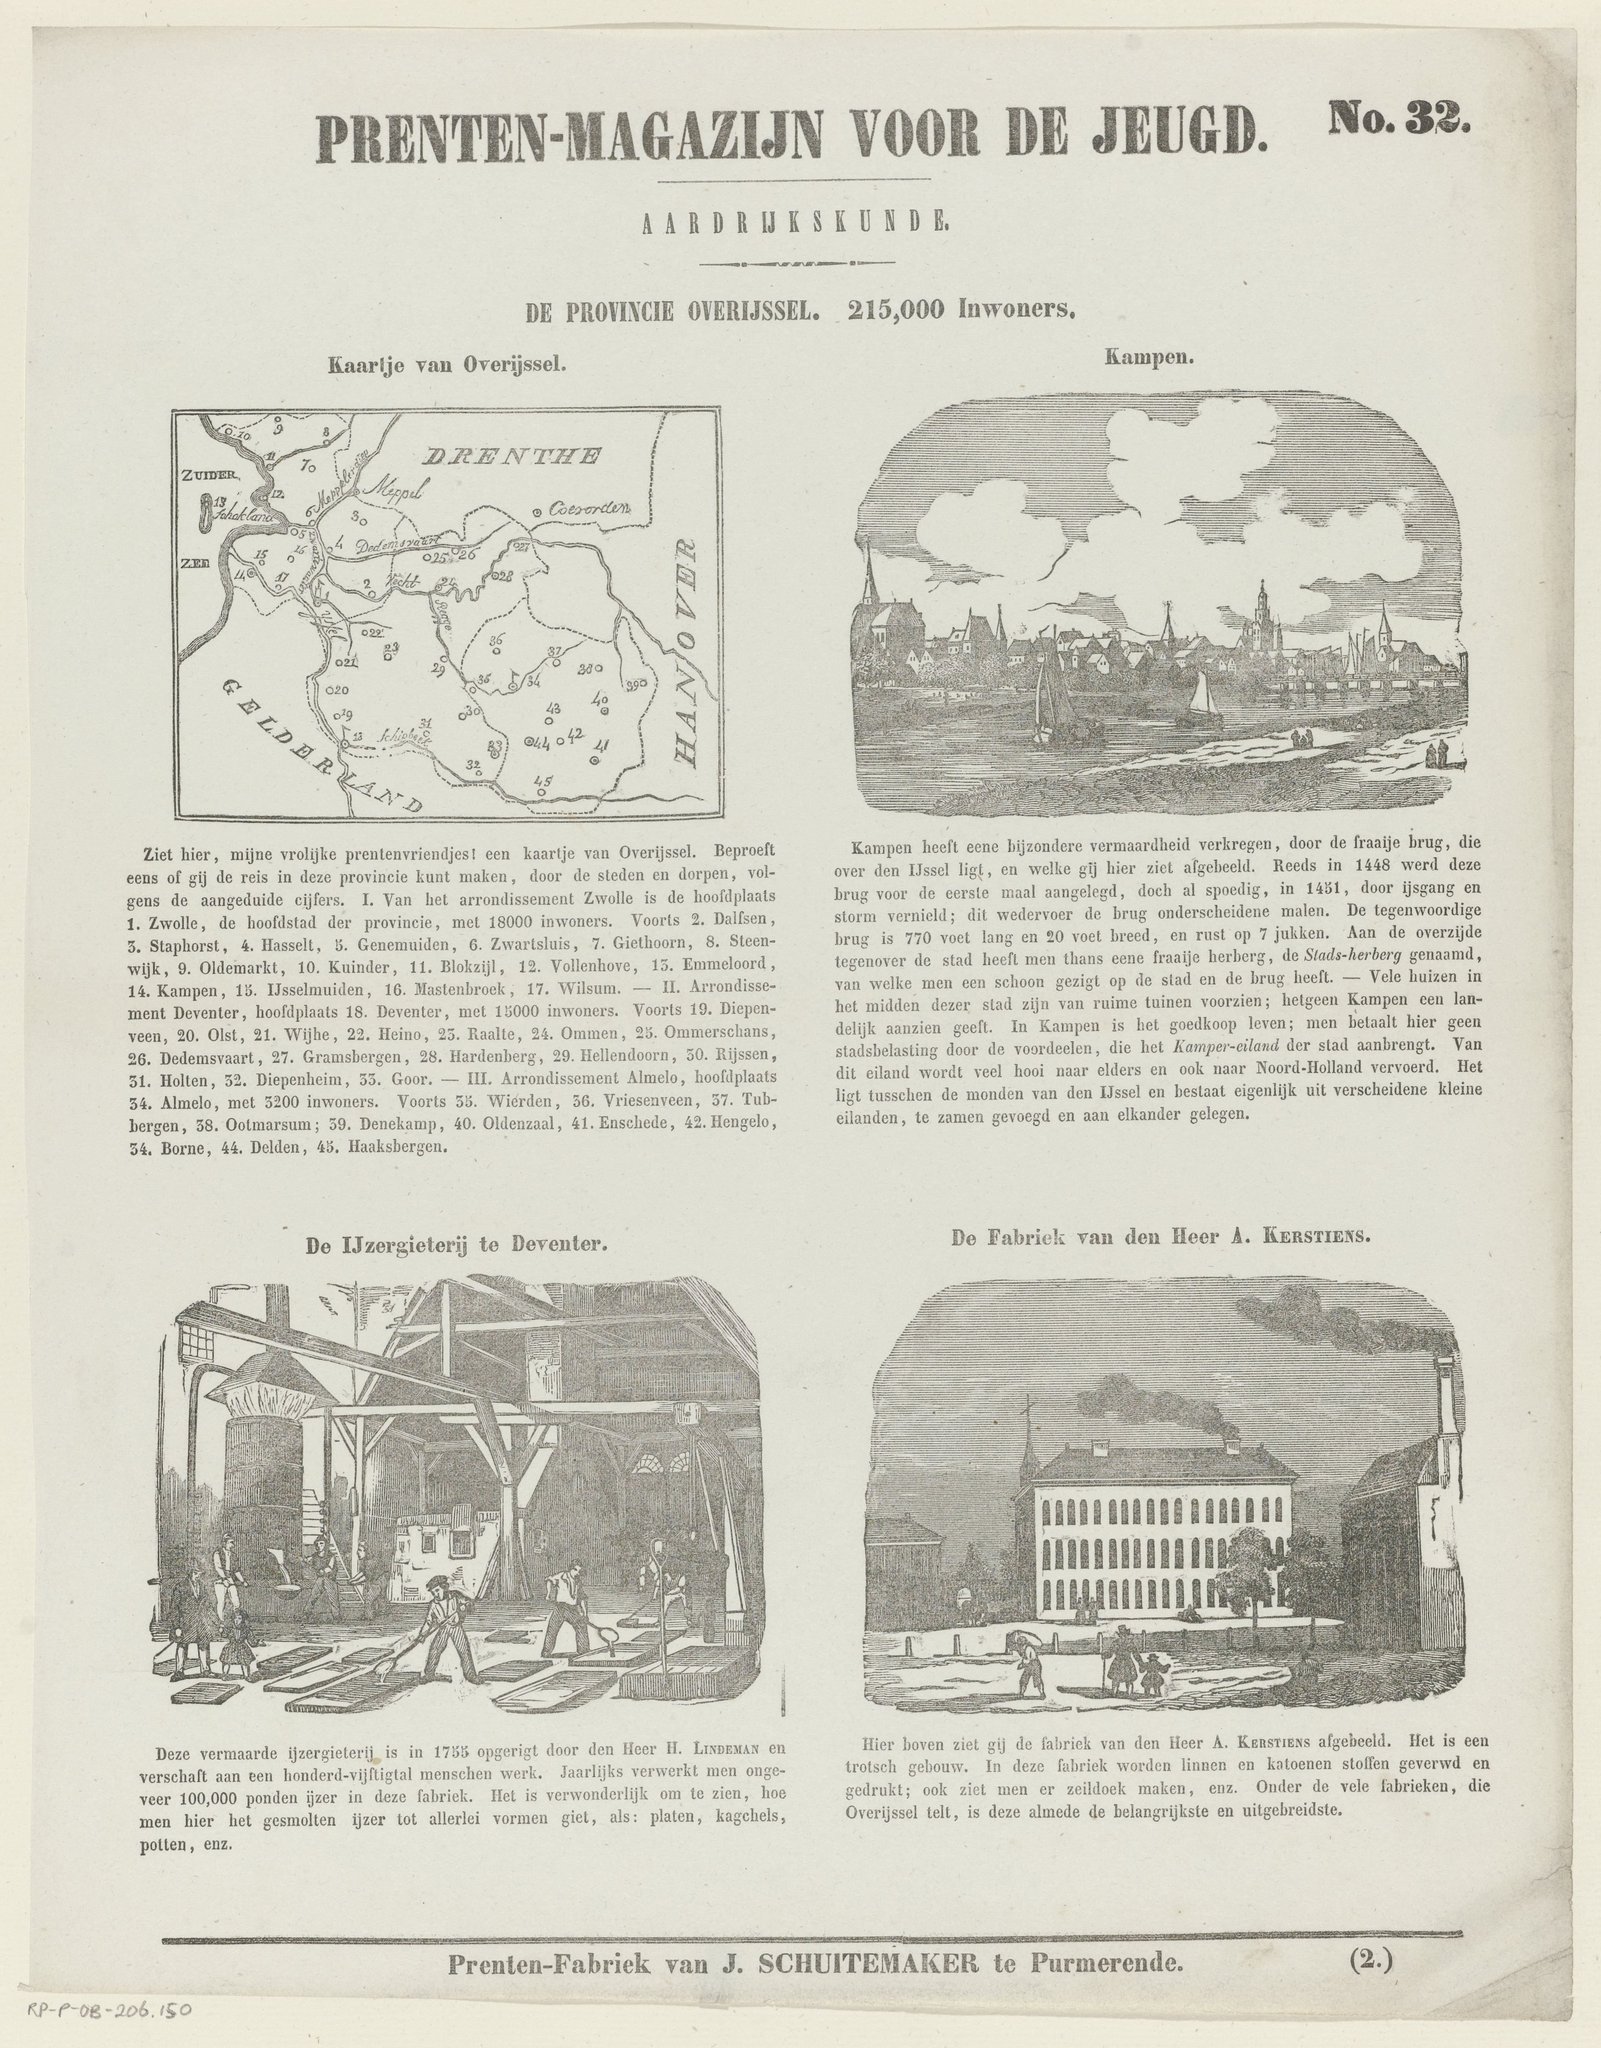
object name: popular print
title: Aardrijkskunde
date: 1850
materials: paper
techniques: letterpress printing, engraving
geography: netherlands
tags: factory-building, iron and steel industry (+ indoors; in laboratory, factory, barn, etc.), maps, atlases, deventer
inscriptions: collector's mark: Lugt 2760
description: Na voltooiing van de acht jaargangen van de reeks 'Prenten-magazijn voor de jeugd' in 1850 heeft Jan Schuitemaker al deze prenten heruitgegeven en omgenummerd als nr. 1 t/m 192. De oorspronkelijke jaargang wordt telkens nog vermeld rechtsonder op de prent. Binnen de jaargangen zijn prenten van hetzelfde thema in clusters van vier achter elkaar gezet.